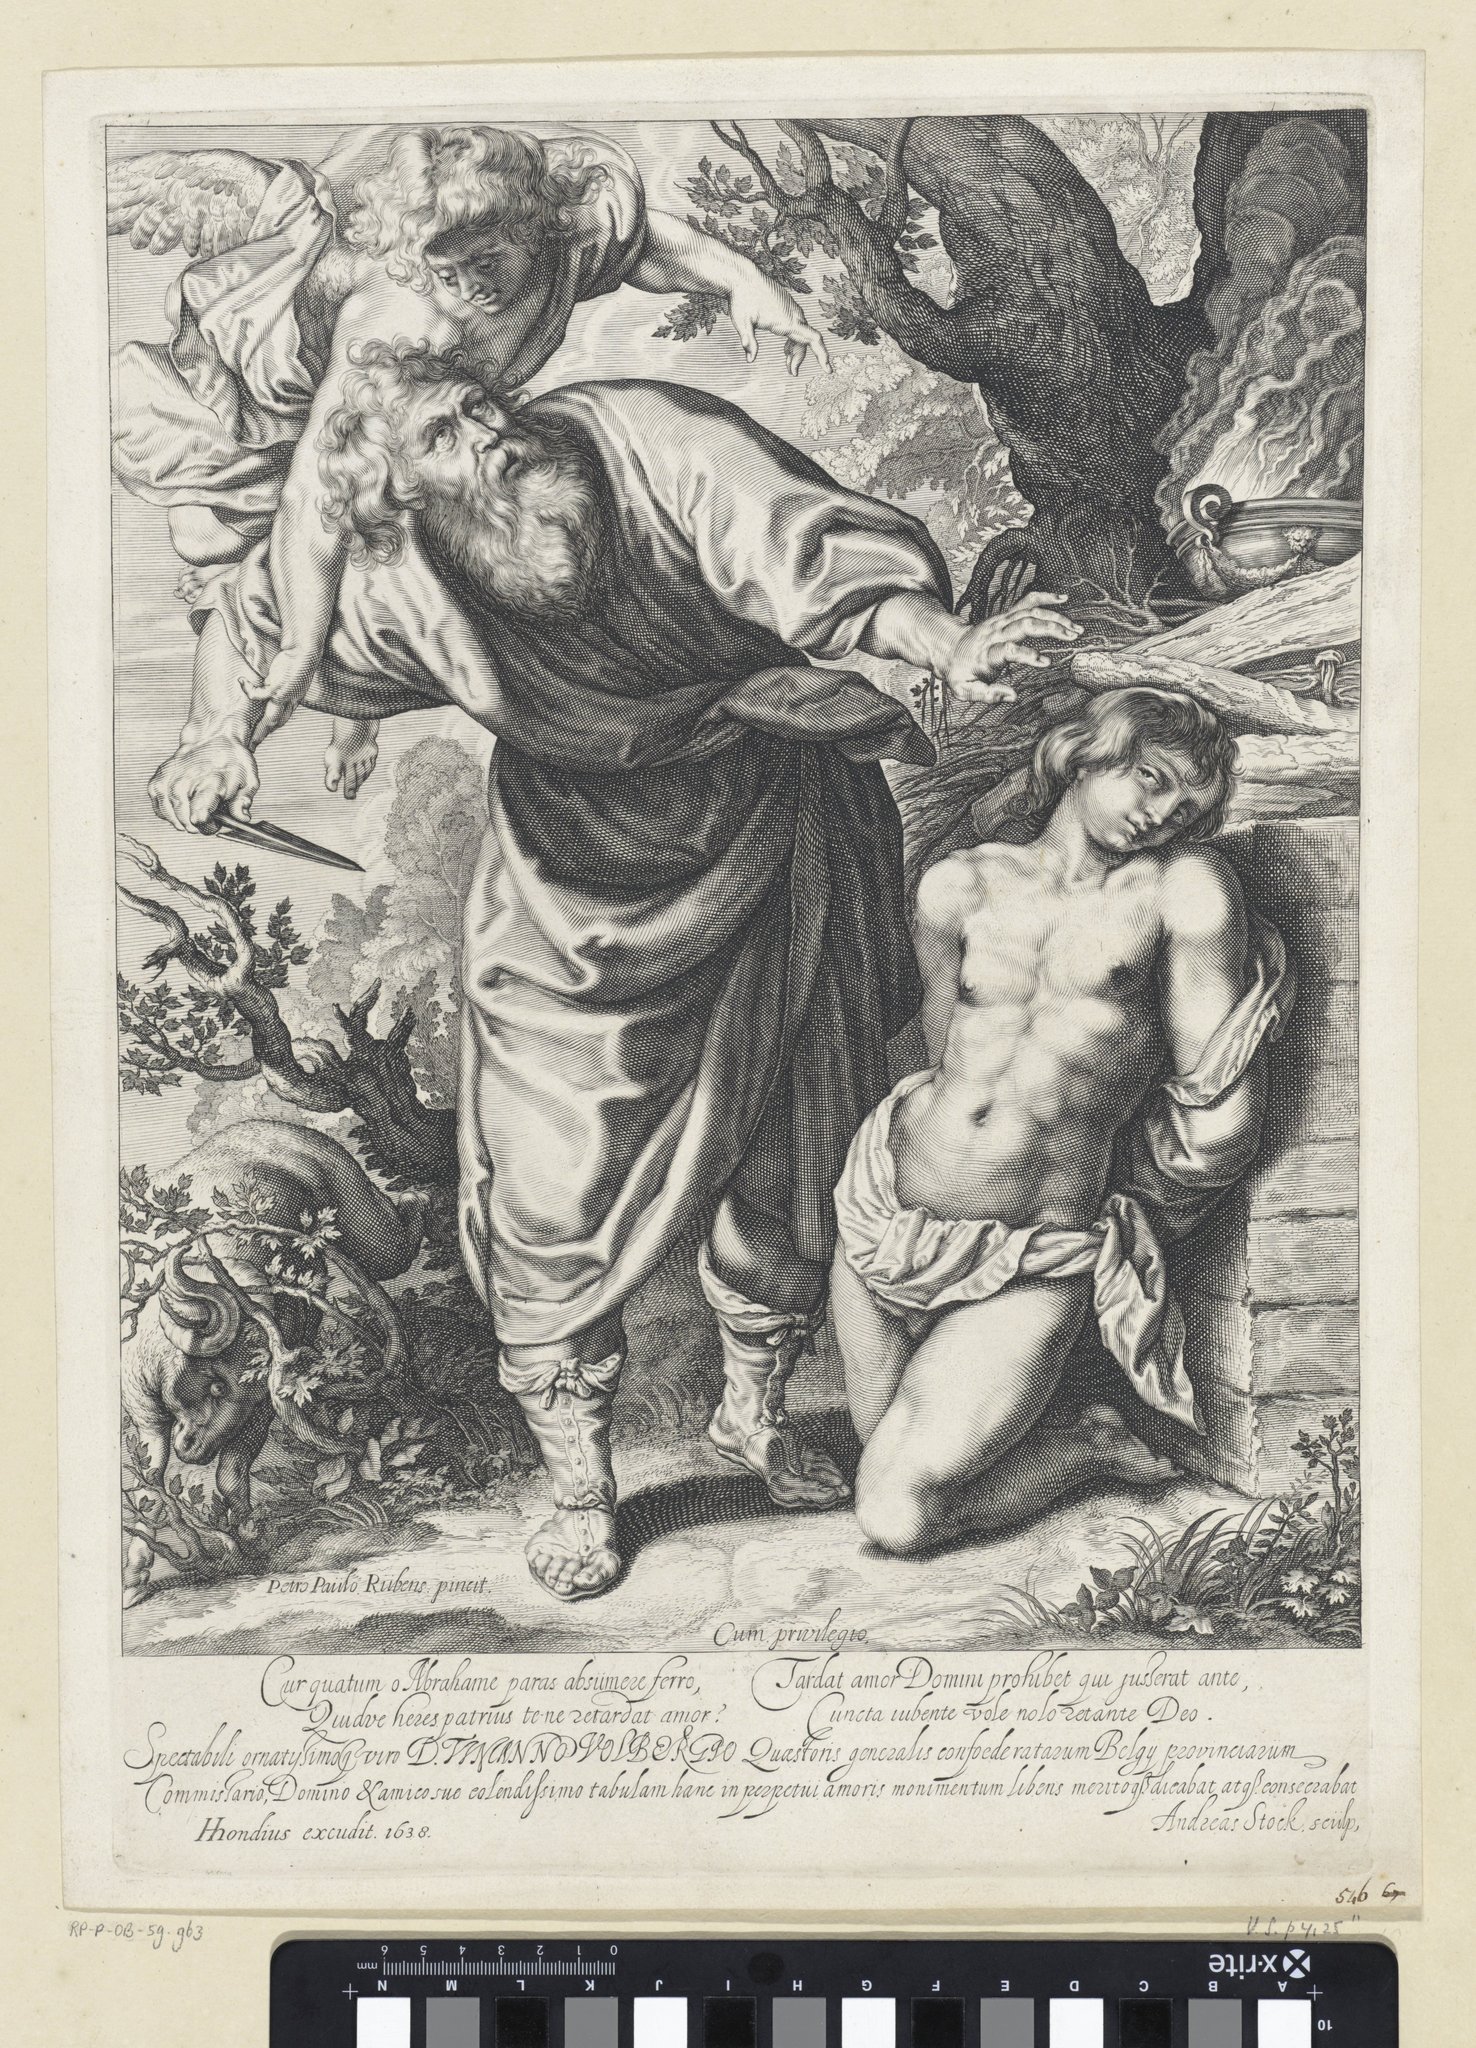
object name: print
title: Offer van Isaak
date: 1638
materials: paper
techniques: engraving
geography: the hague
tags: the sacrifice of isaac (genesis 22)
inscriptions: collector's mark: Lugt 240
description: Abraham, met een mes in de hand, staat op het punt zijn zoon Isaak te offeren, maar een engel weerhoudt hem daarvan. Links een ram in de struiken, die in Isaaks plaats zal worden geofferd.